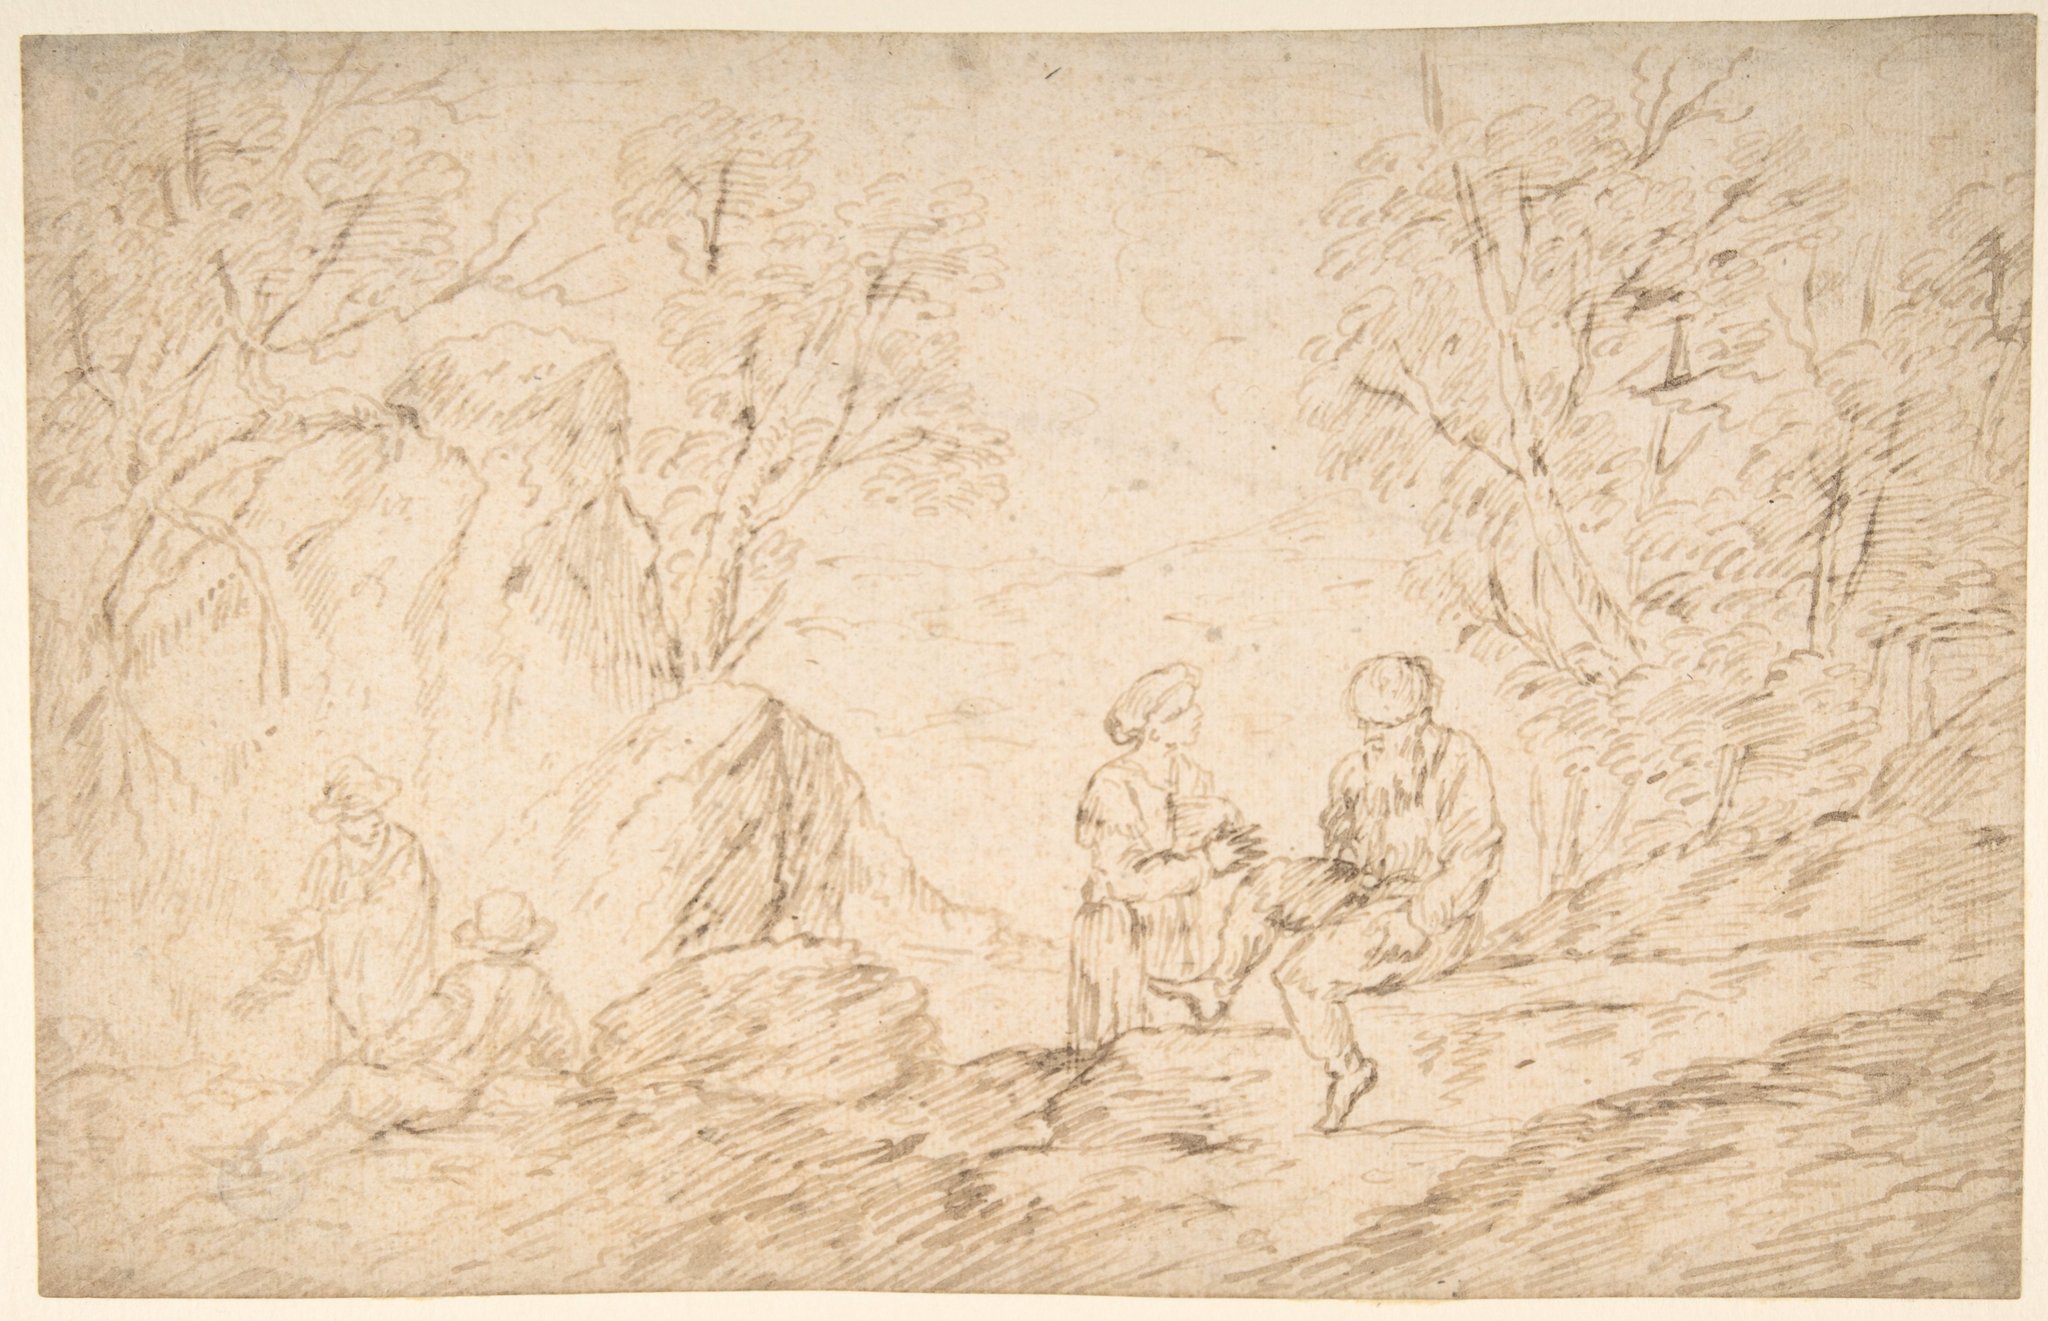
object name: drawing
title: Four Figures Conversing in a Landscape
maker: antonio del castillo y saavedra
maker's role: artist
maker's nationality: spanish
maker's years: 1616-1668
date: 1616-1668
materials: ink, paper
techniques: pen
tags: men,women,landscapes